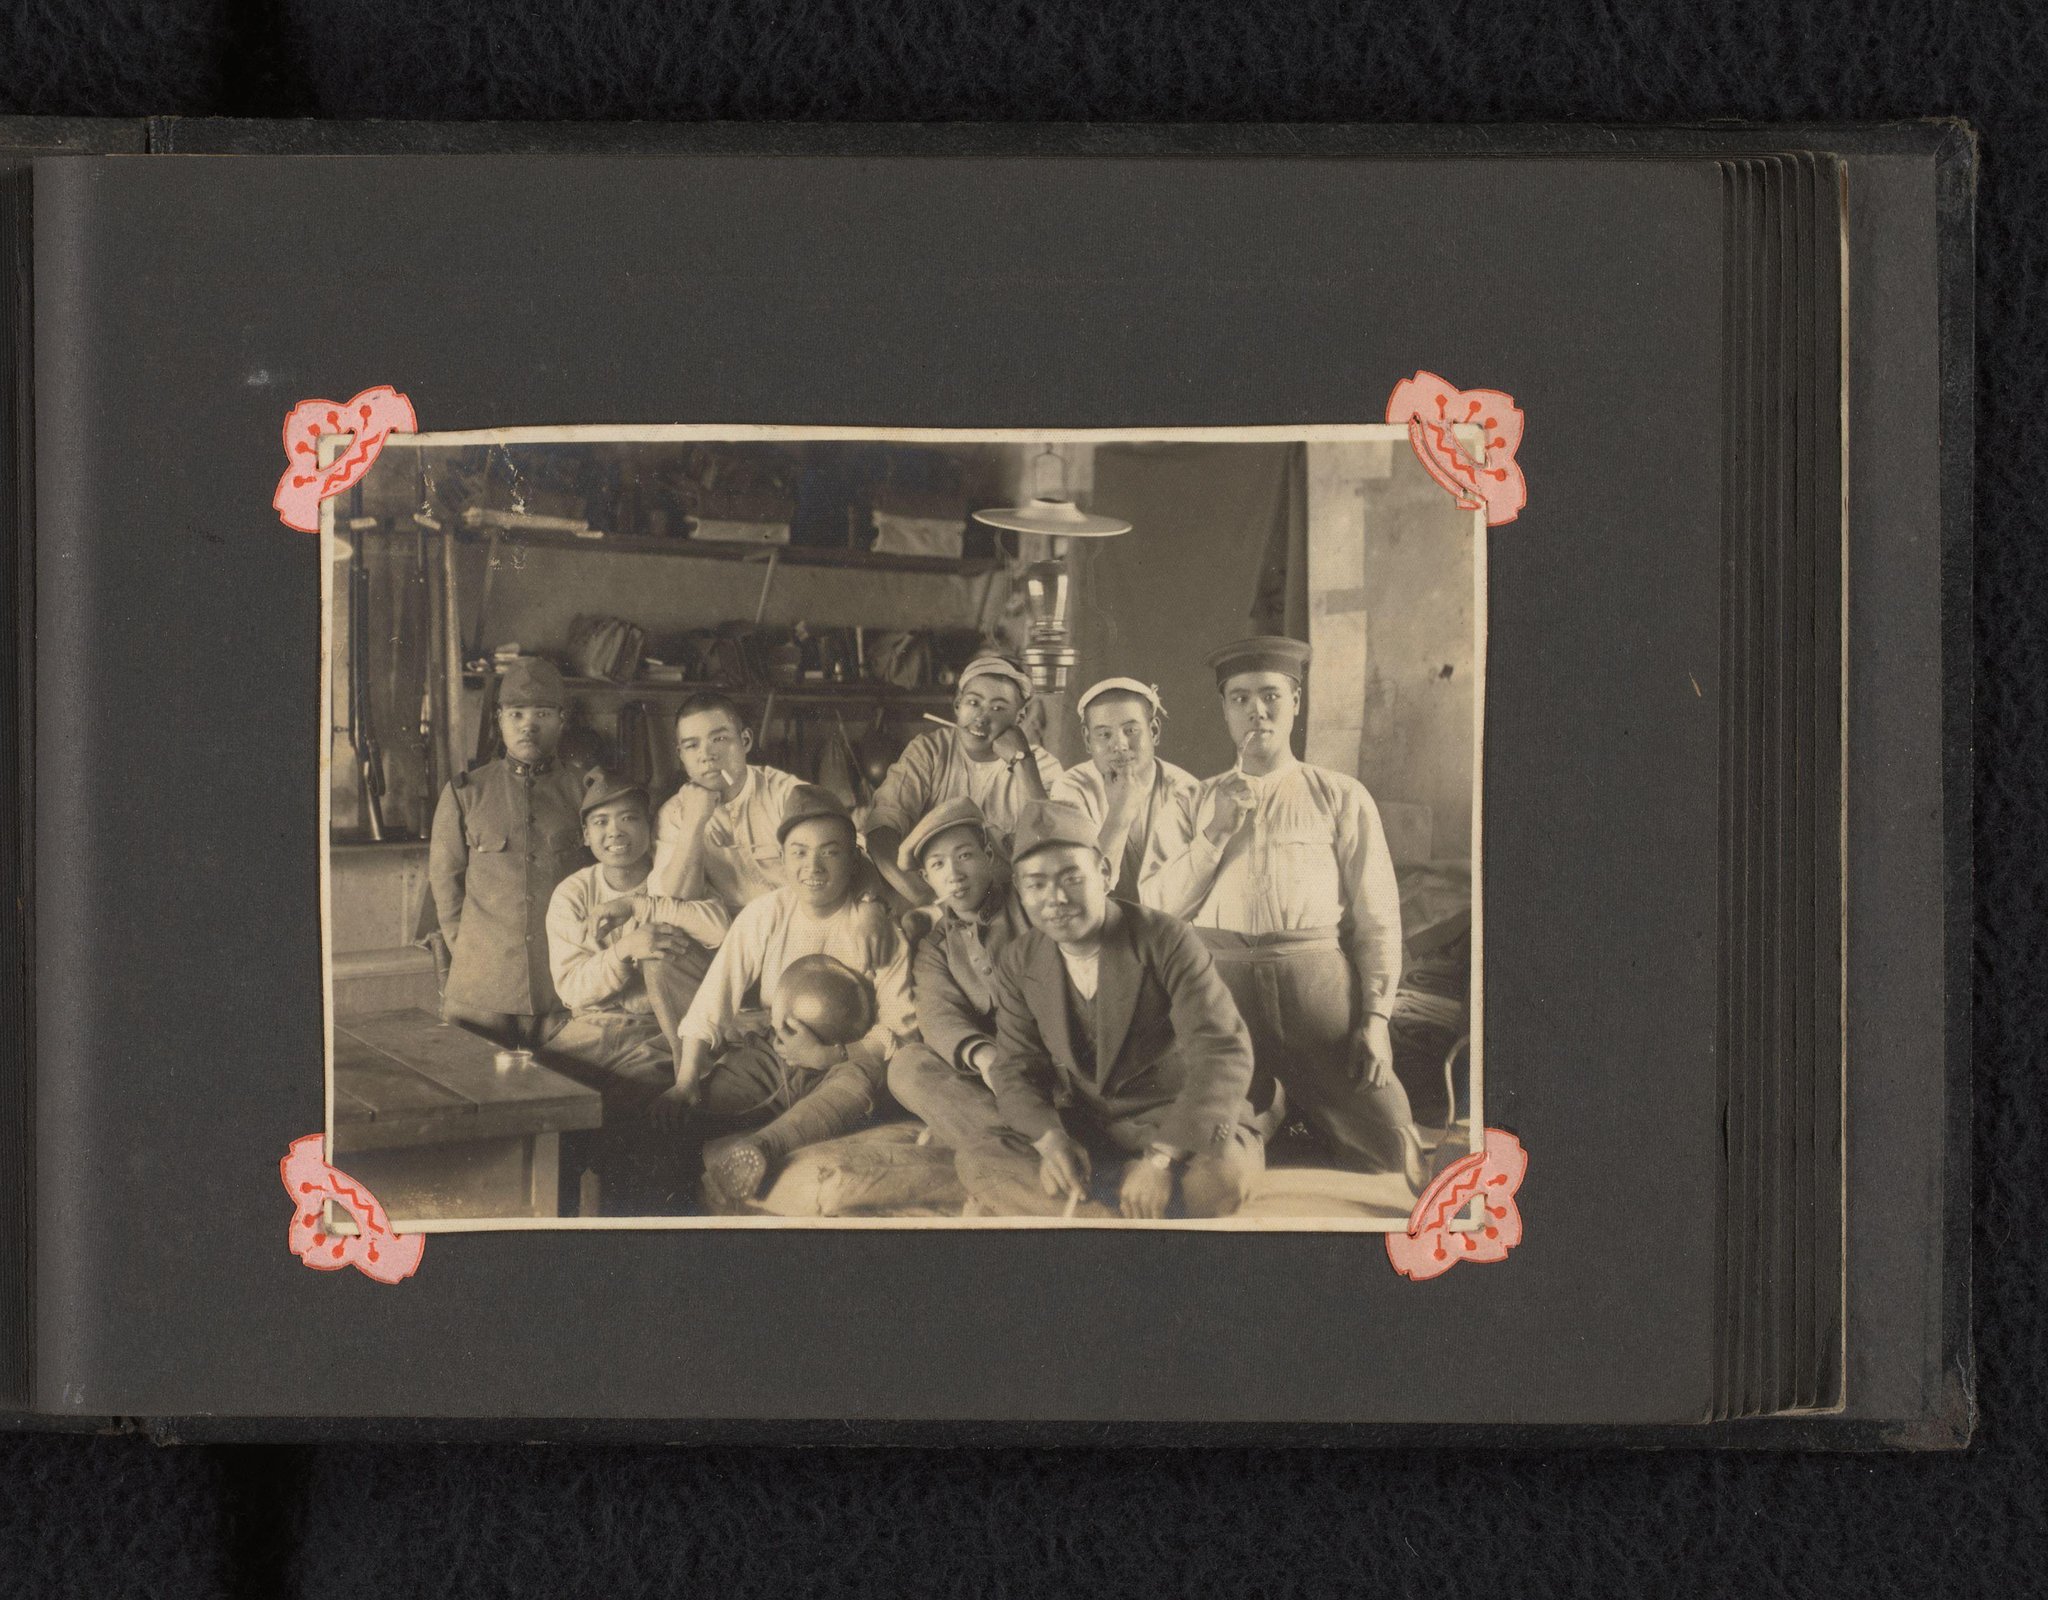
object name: album leaf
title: Groepsportret van onbekende Japanse militairen in een barak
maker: Anonymous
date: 1937-1941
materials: paper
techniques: gelatin silver print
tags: the soldier; the soldier's life, barracks